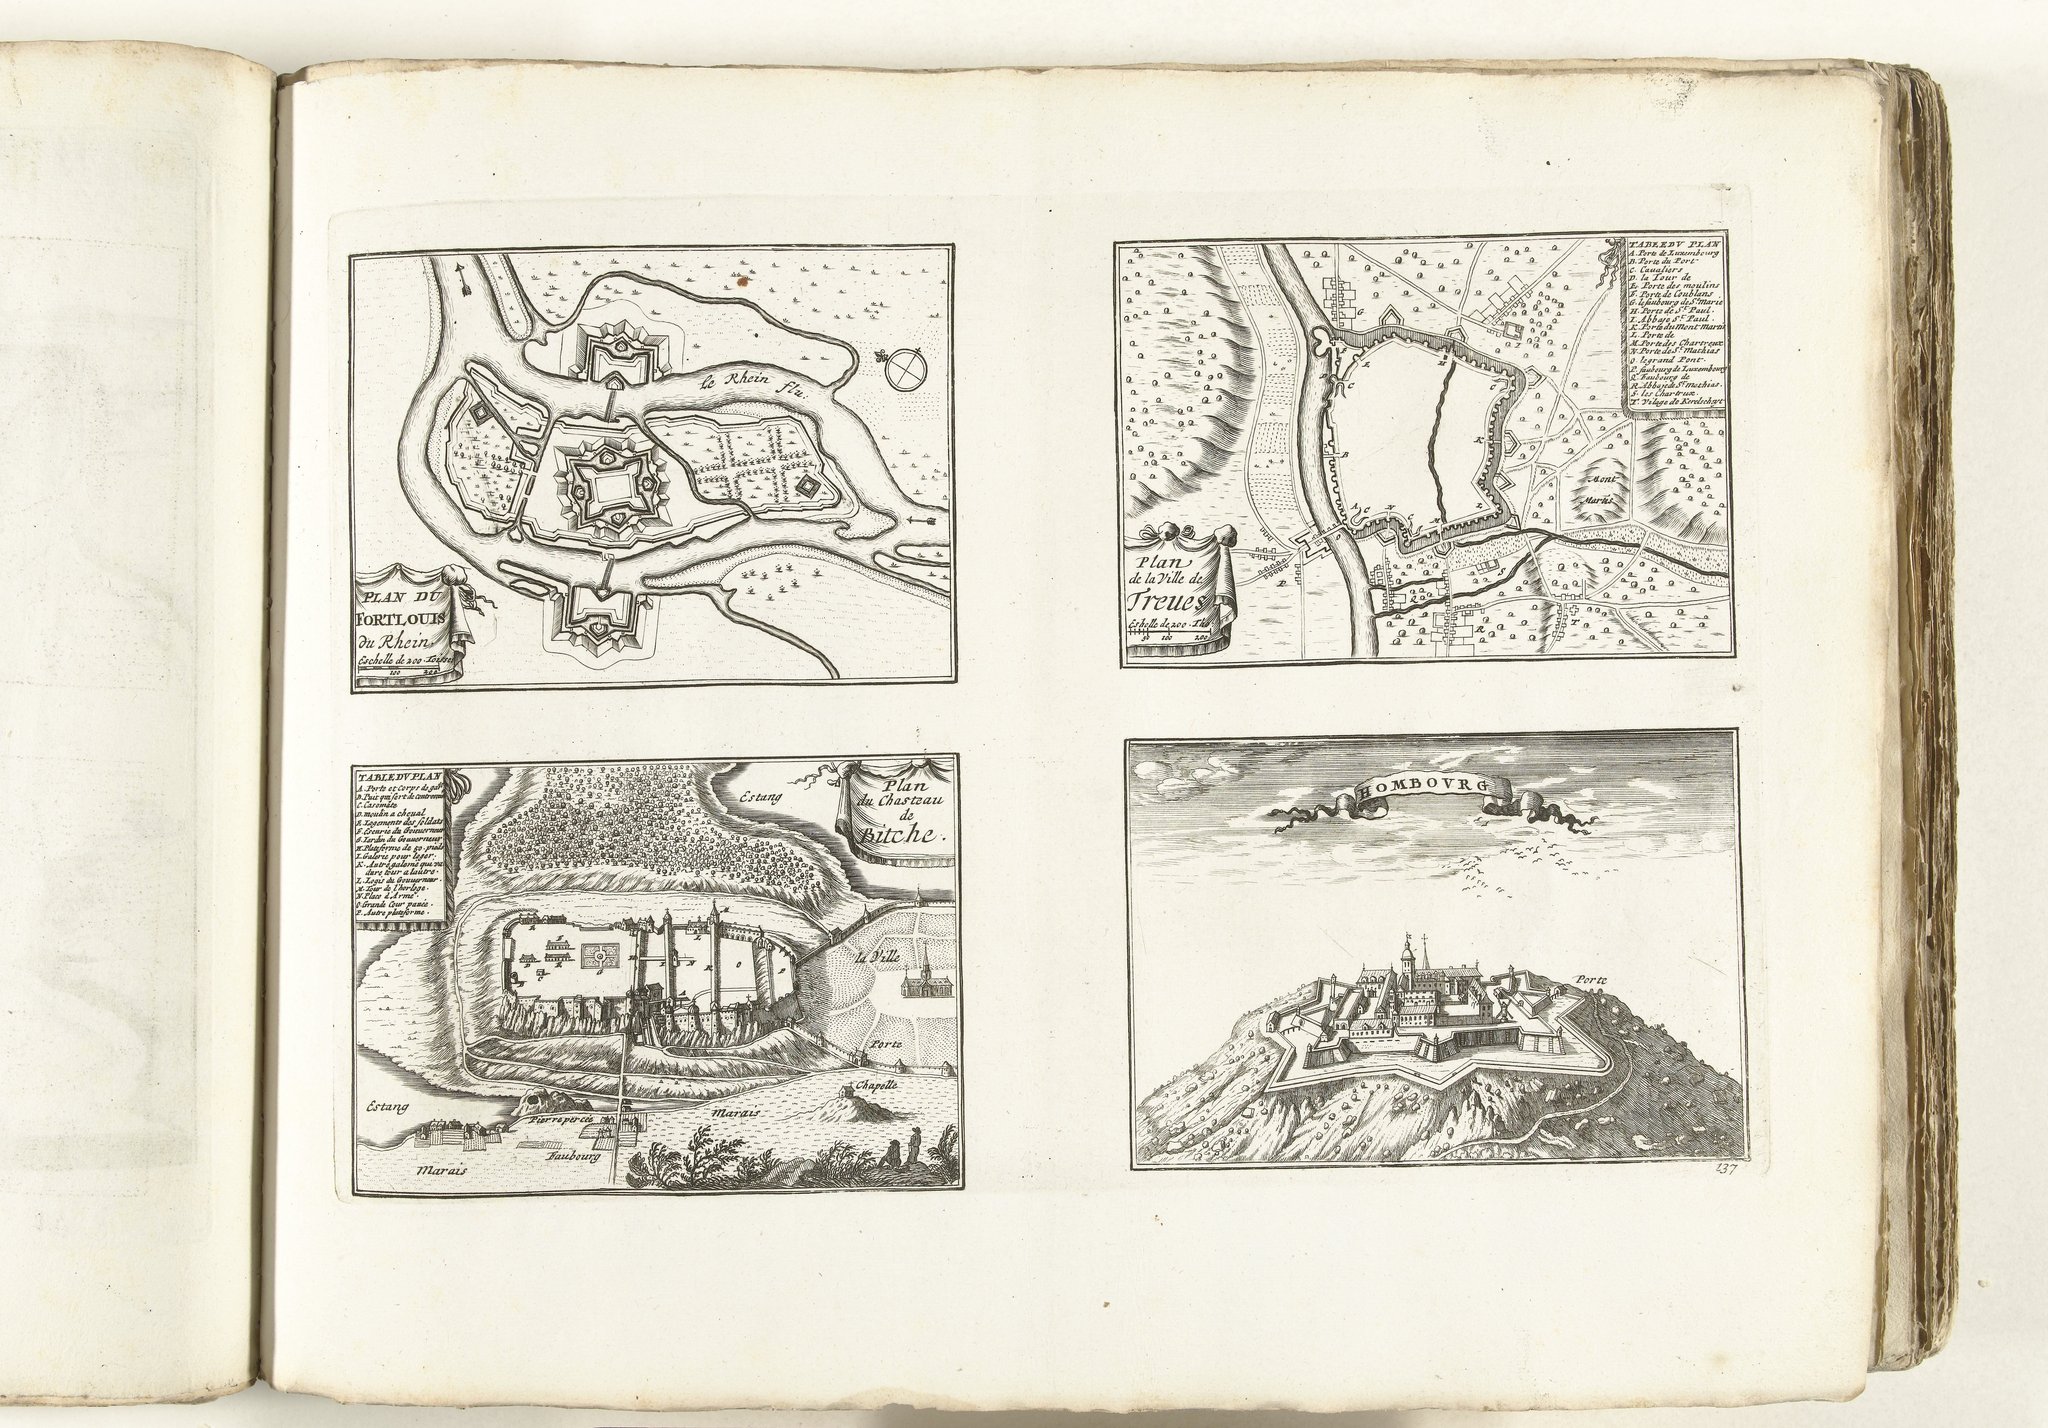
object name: map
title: Kaarten van Fort Louis, Trier, Biche en Homburg, ca. 1702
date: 1702-1703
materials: paper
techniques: engraving, etching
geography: amsterdam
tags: fortress, maps of cities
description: Blad met twee plattegronden van de versterkingen en twee gezichten op Fort Louis, Trier, Biche en Homburg. Plaat nr. 137 in het prentwerk bestaande in totaal uit 276 genummerde platen van vermaarde sterke steden en vestingen in het kader van de Spaanse Successieoorlog. Voor het merendeel zijn deze platen gekopieerd naar de anonieme Franse platen: in Les forces de l'Europe en in: Le theatre de la guerre, dans les Pays-Bas, beide oorspronkelijk uitgegeven door Nicolas de Fer te Parijs (1693-1697) in het kader van de Negenjarige Oorlog. Titels en opschriften in de plaat in het Frans.